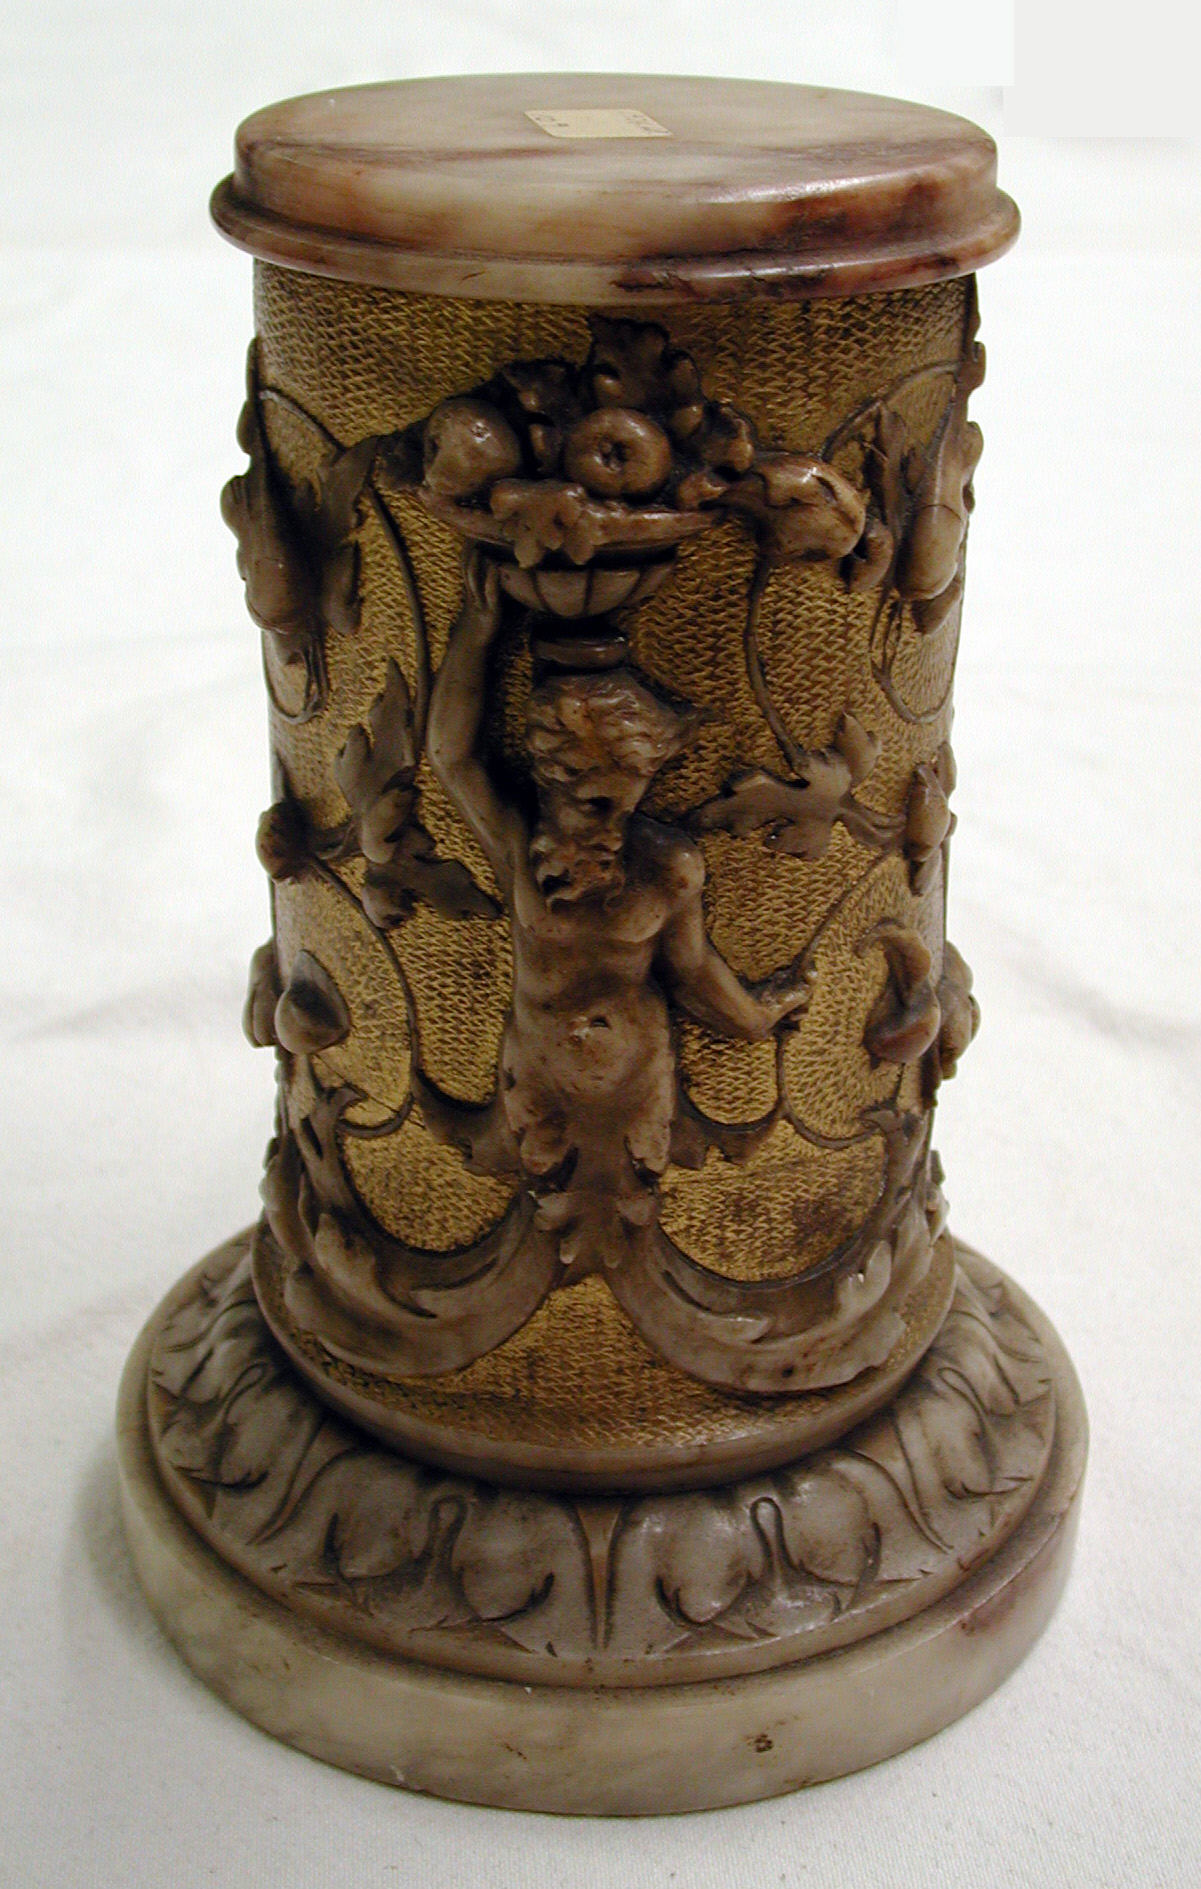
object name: pedestal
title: Pedestal (one of a pair)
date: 1501-1600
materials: alabaster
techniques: gilding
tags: men